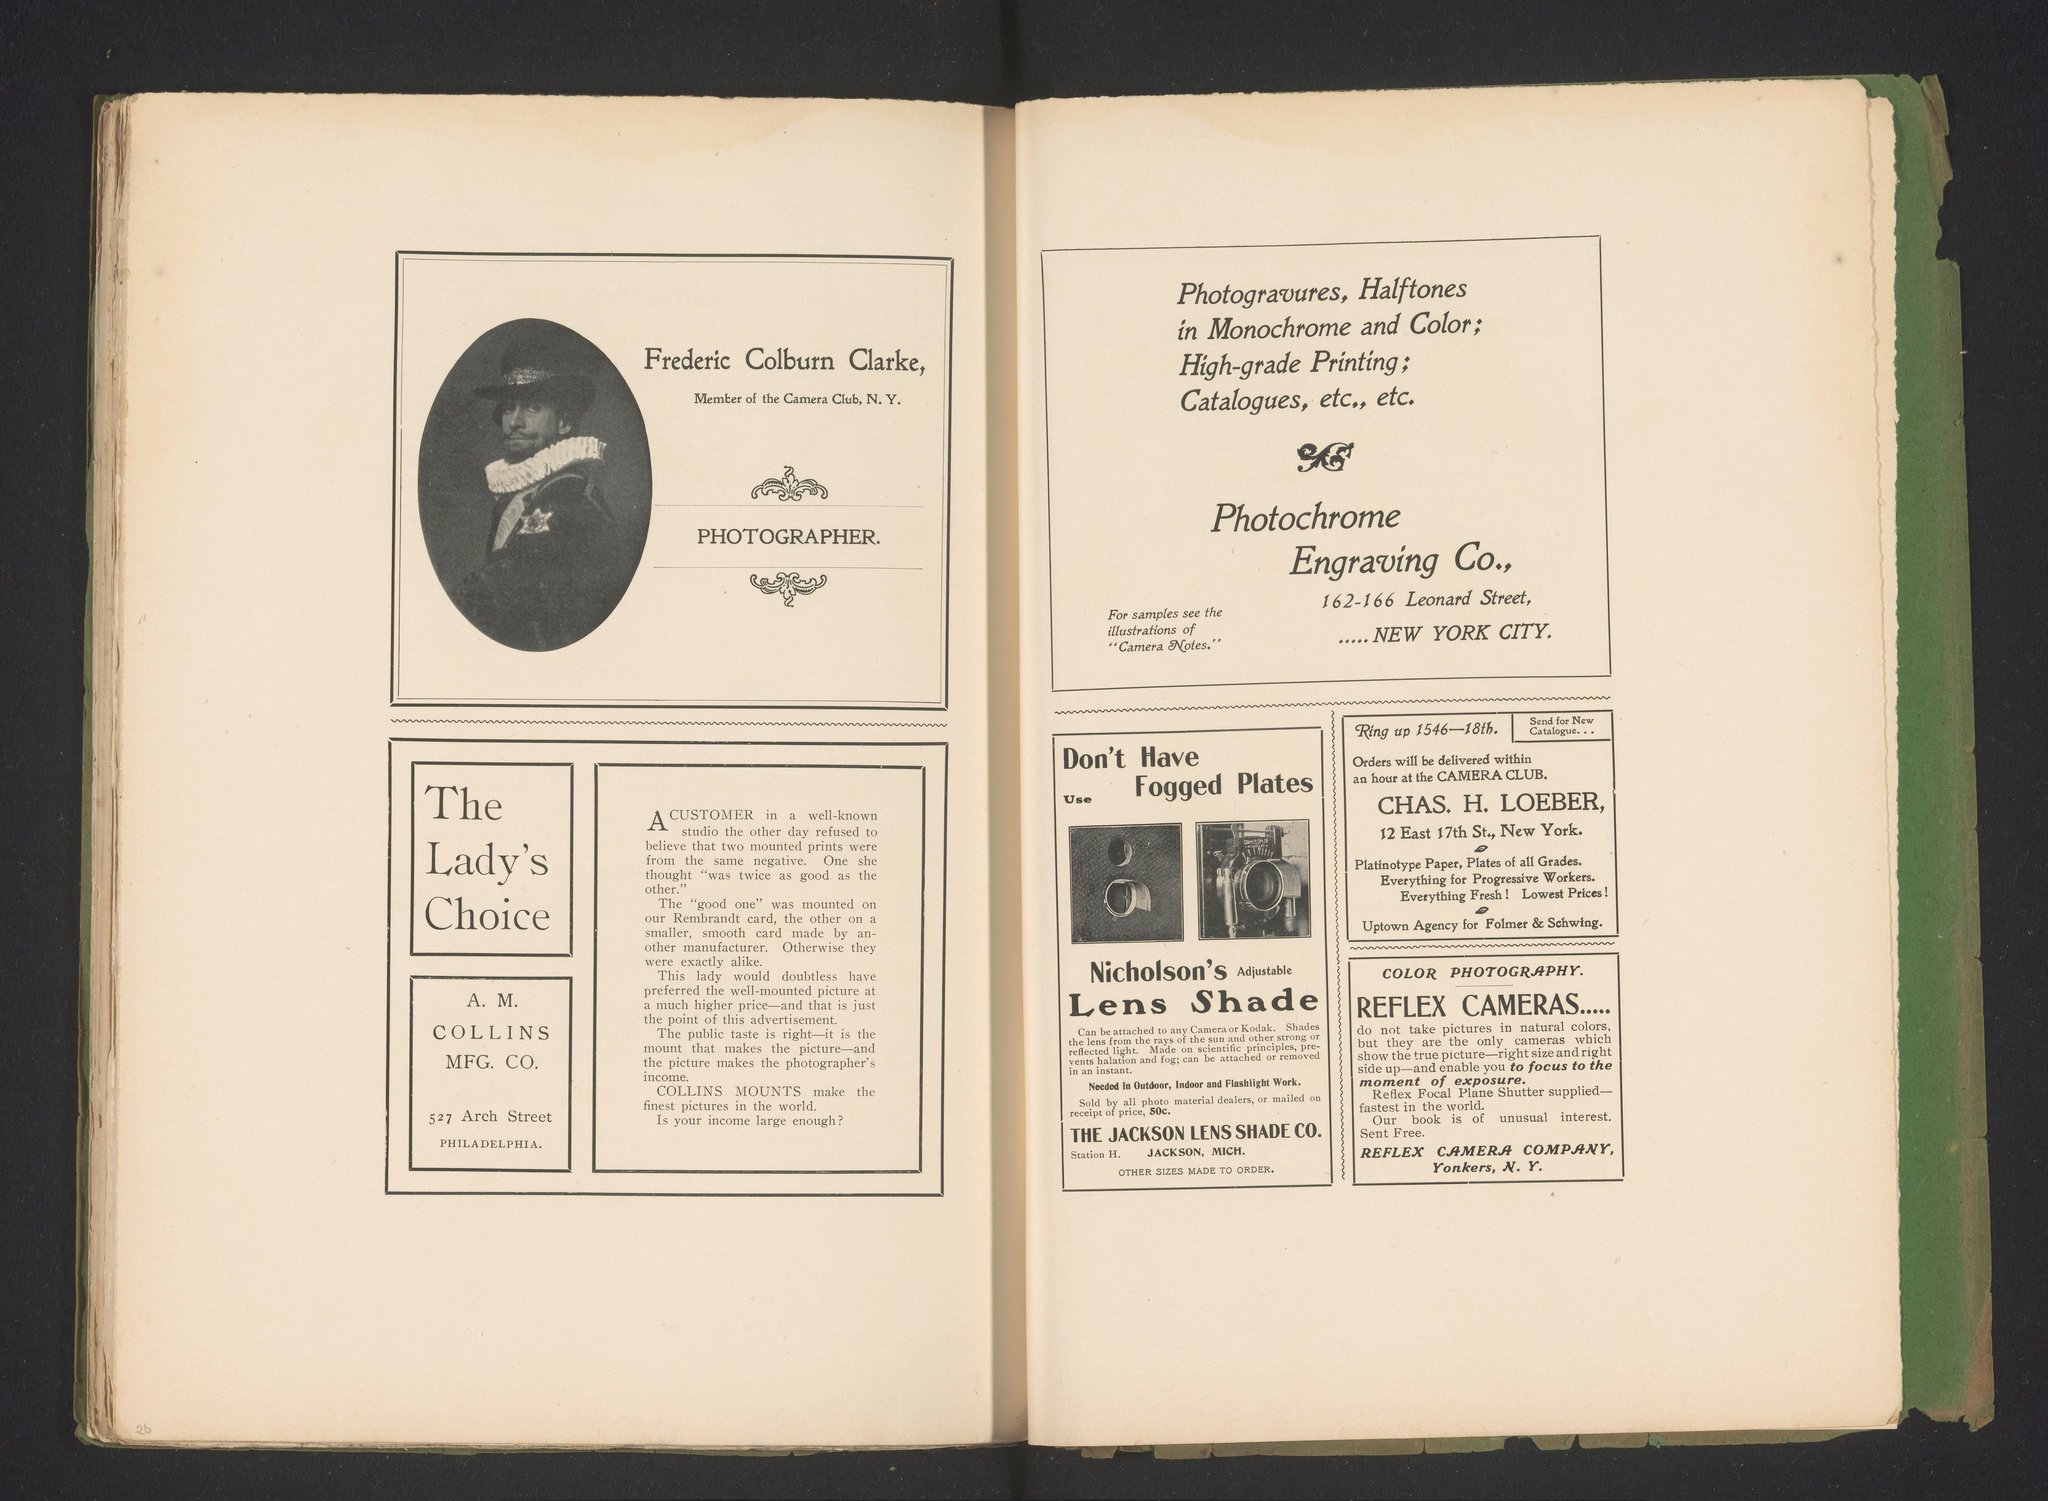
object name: page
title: Detail van de voorkant van een camera met zonnekap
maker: Anonymous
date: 1896-1901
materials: paper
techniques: autotype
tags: camera ~ photography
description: Prent in katern advertenties achterin boek. Prent is onderdeel van een advertentie van The Jackson Lens Shade Co.